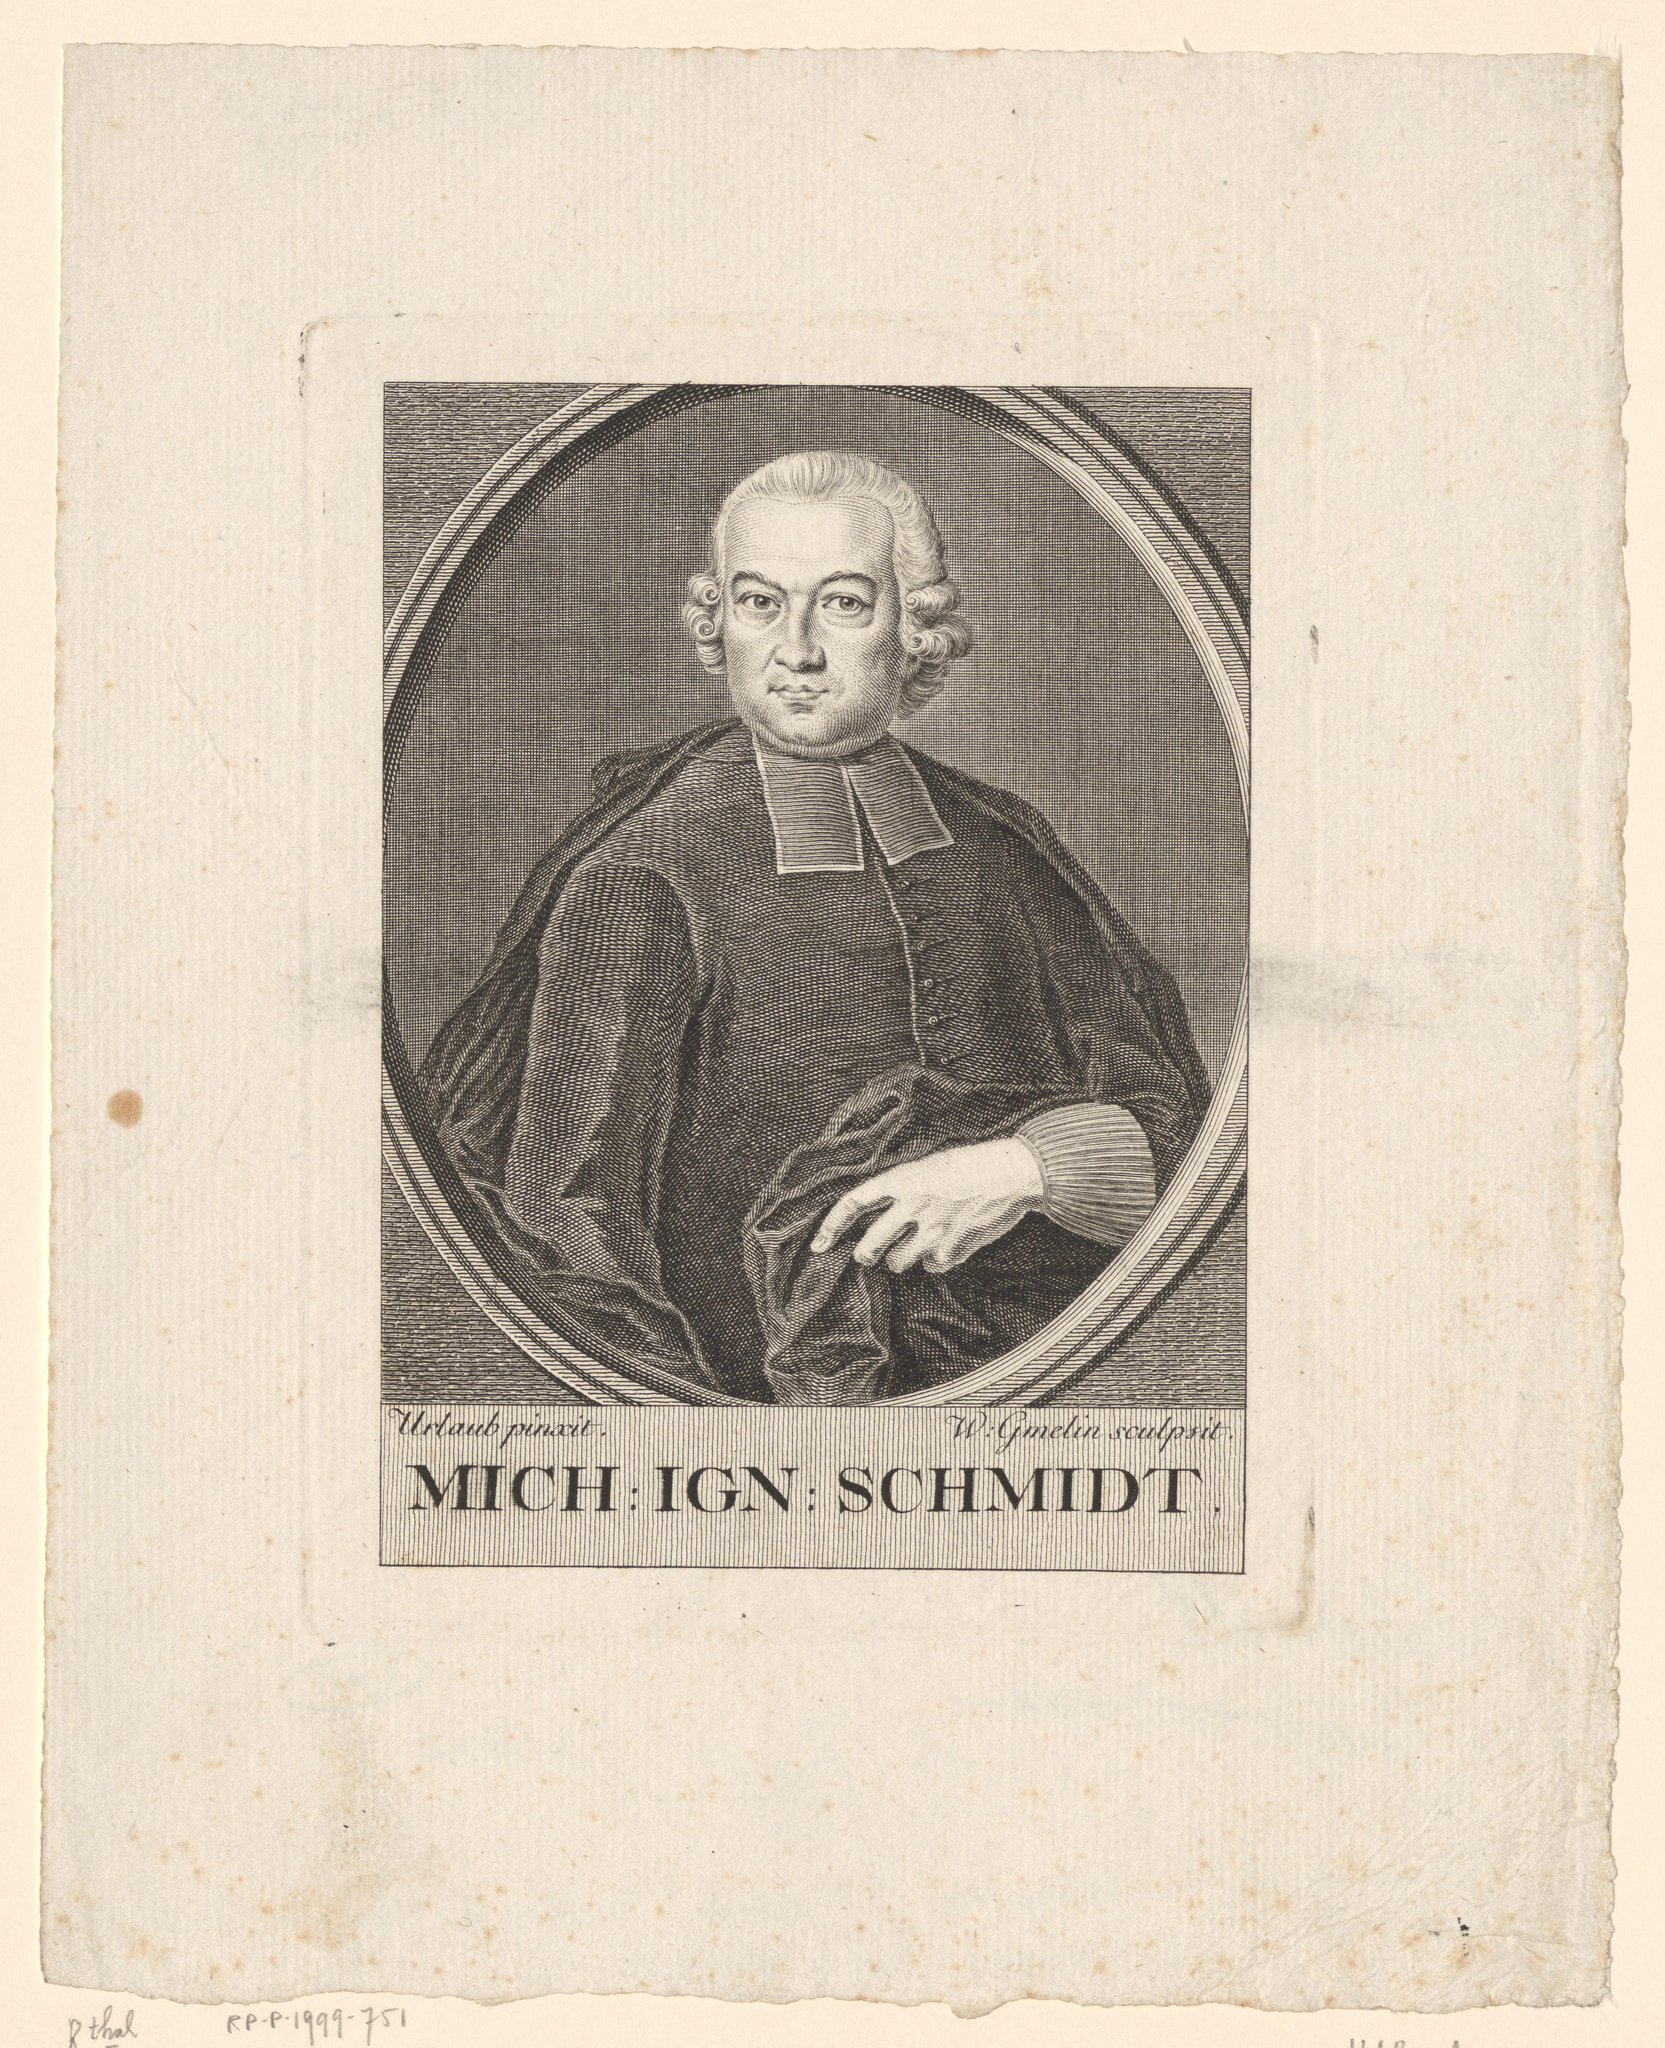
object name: print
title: Portret van Michael Ignaz Schmidt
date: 1770-1820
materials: paper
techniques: engraving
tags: vienna, theologian, historical persons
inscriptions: collector's mark: Lugt 2228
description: Portret van Michael Ignaz Schmidt (1736-1794): katholiek theoloog. Portret in toga, ten halven lijve, naar links, in ovaal.